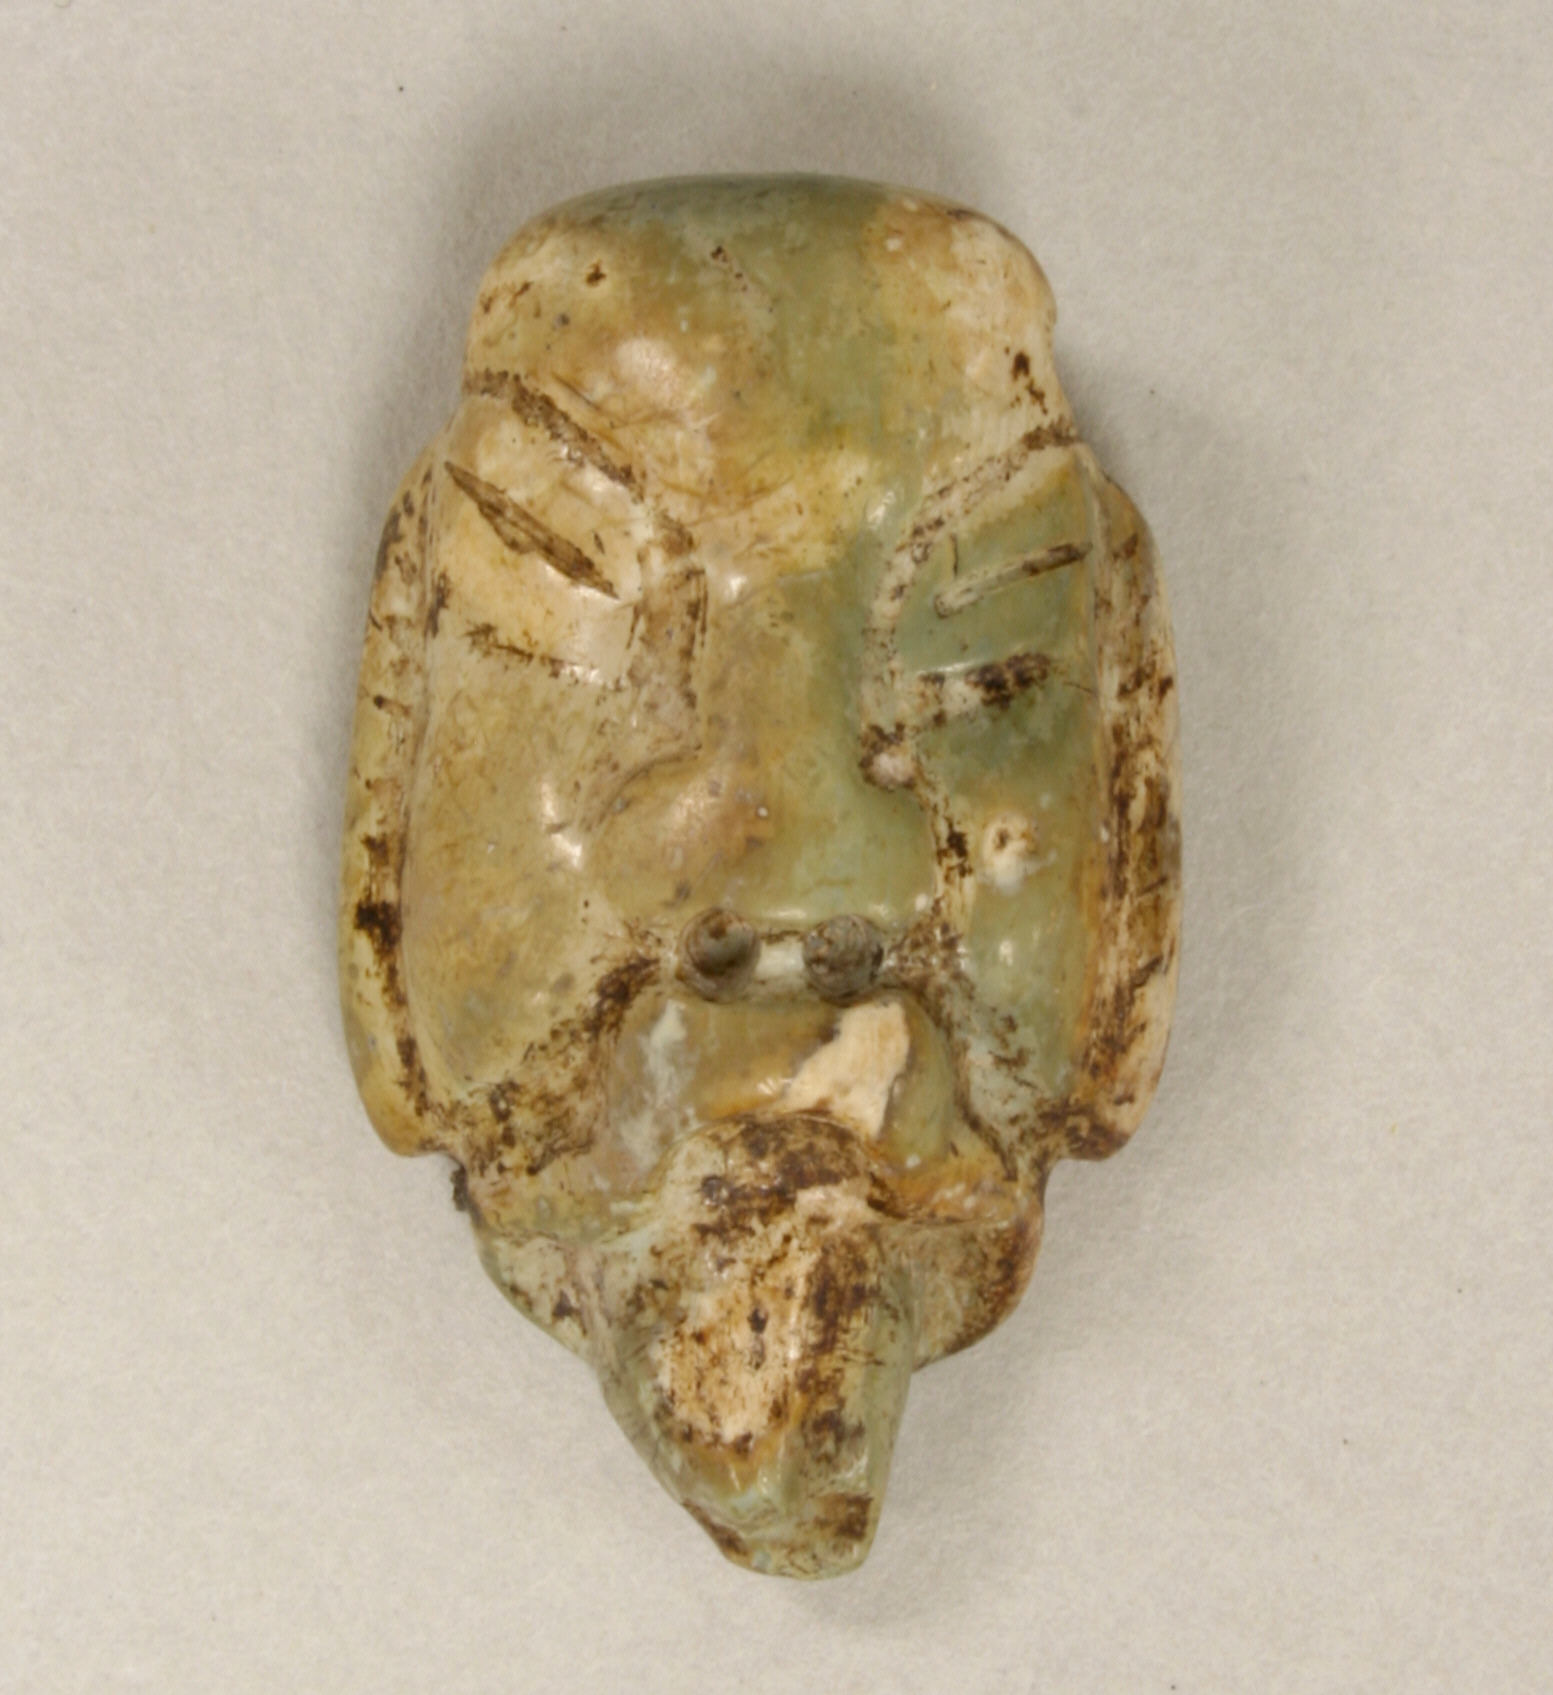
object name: head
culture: mexican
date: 600-101 BCE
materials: stone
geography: mexico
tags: heads